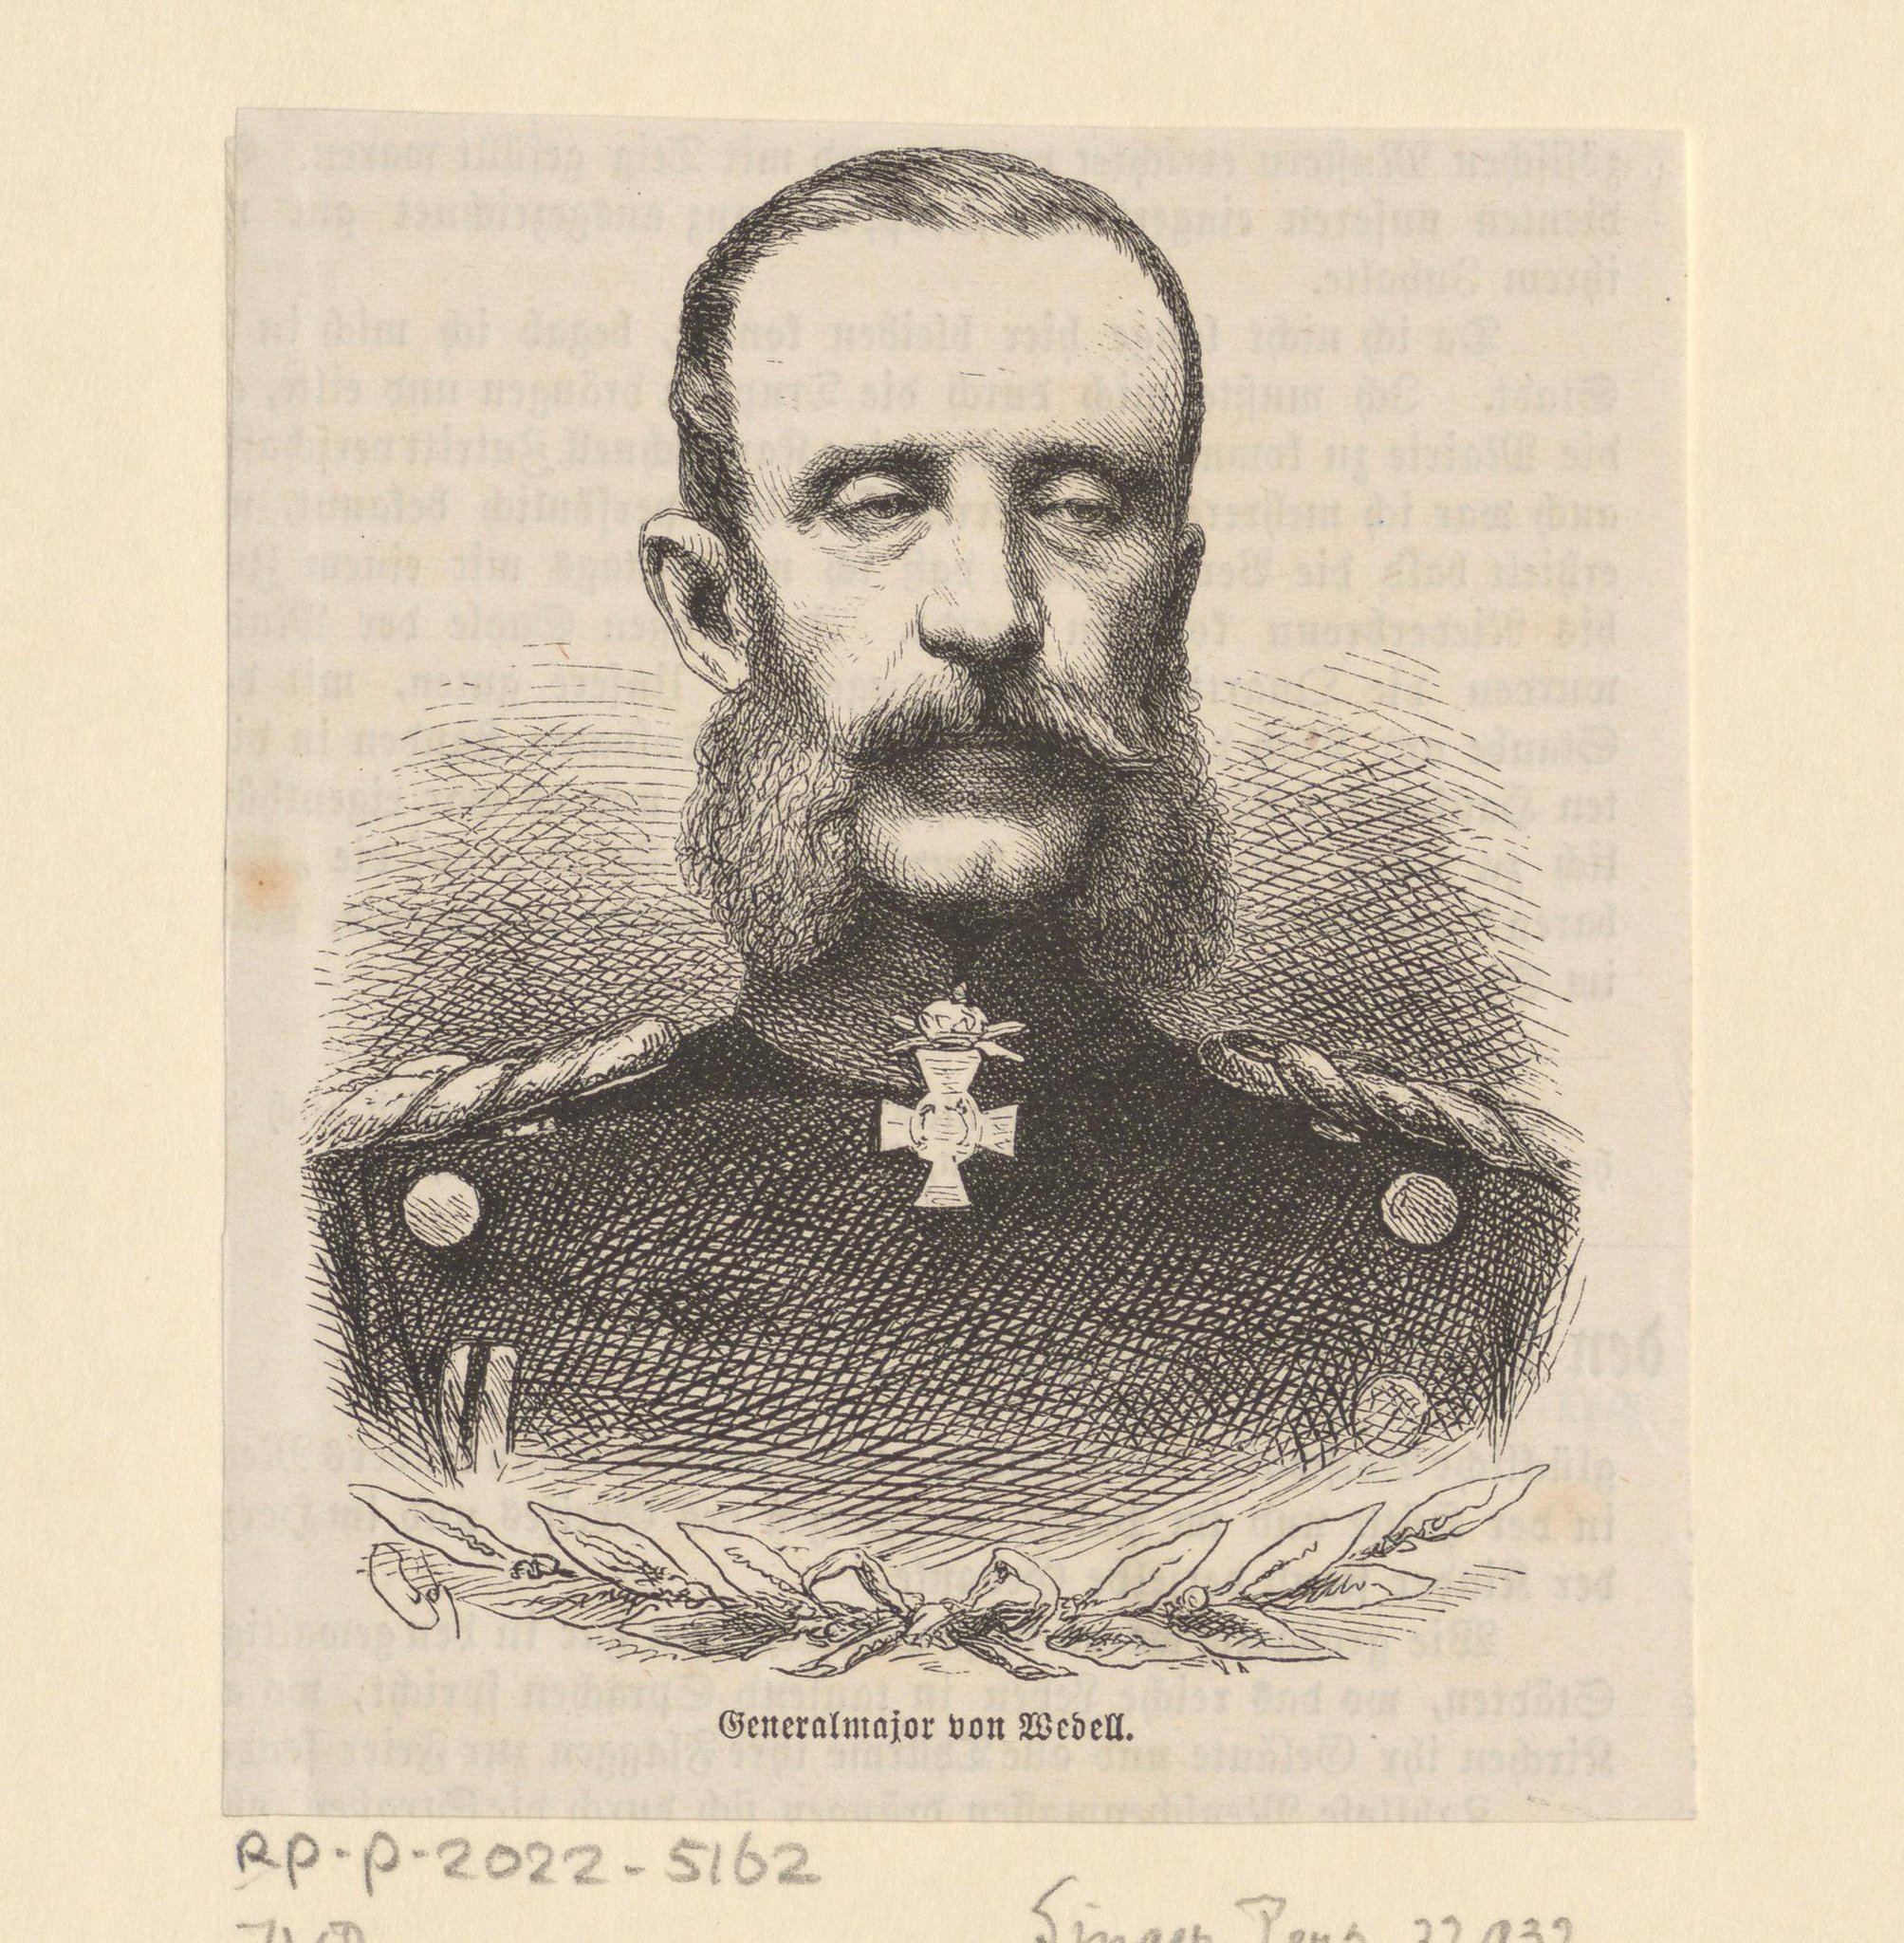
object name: print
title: Portret van Heinrich Wedel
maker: Anonymous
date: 1809-1870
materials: paper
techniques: letterpress printing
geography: germany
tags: berlin, historical persons, medals and other marks of military honour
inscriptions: collector's mark: ‘JVB’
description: Prent uit: Daheim, nr. 50, september 1870.